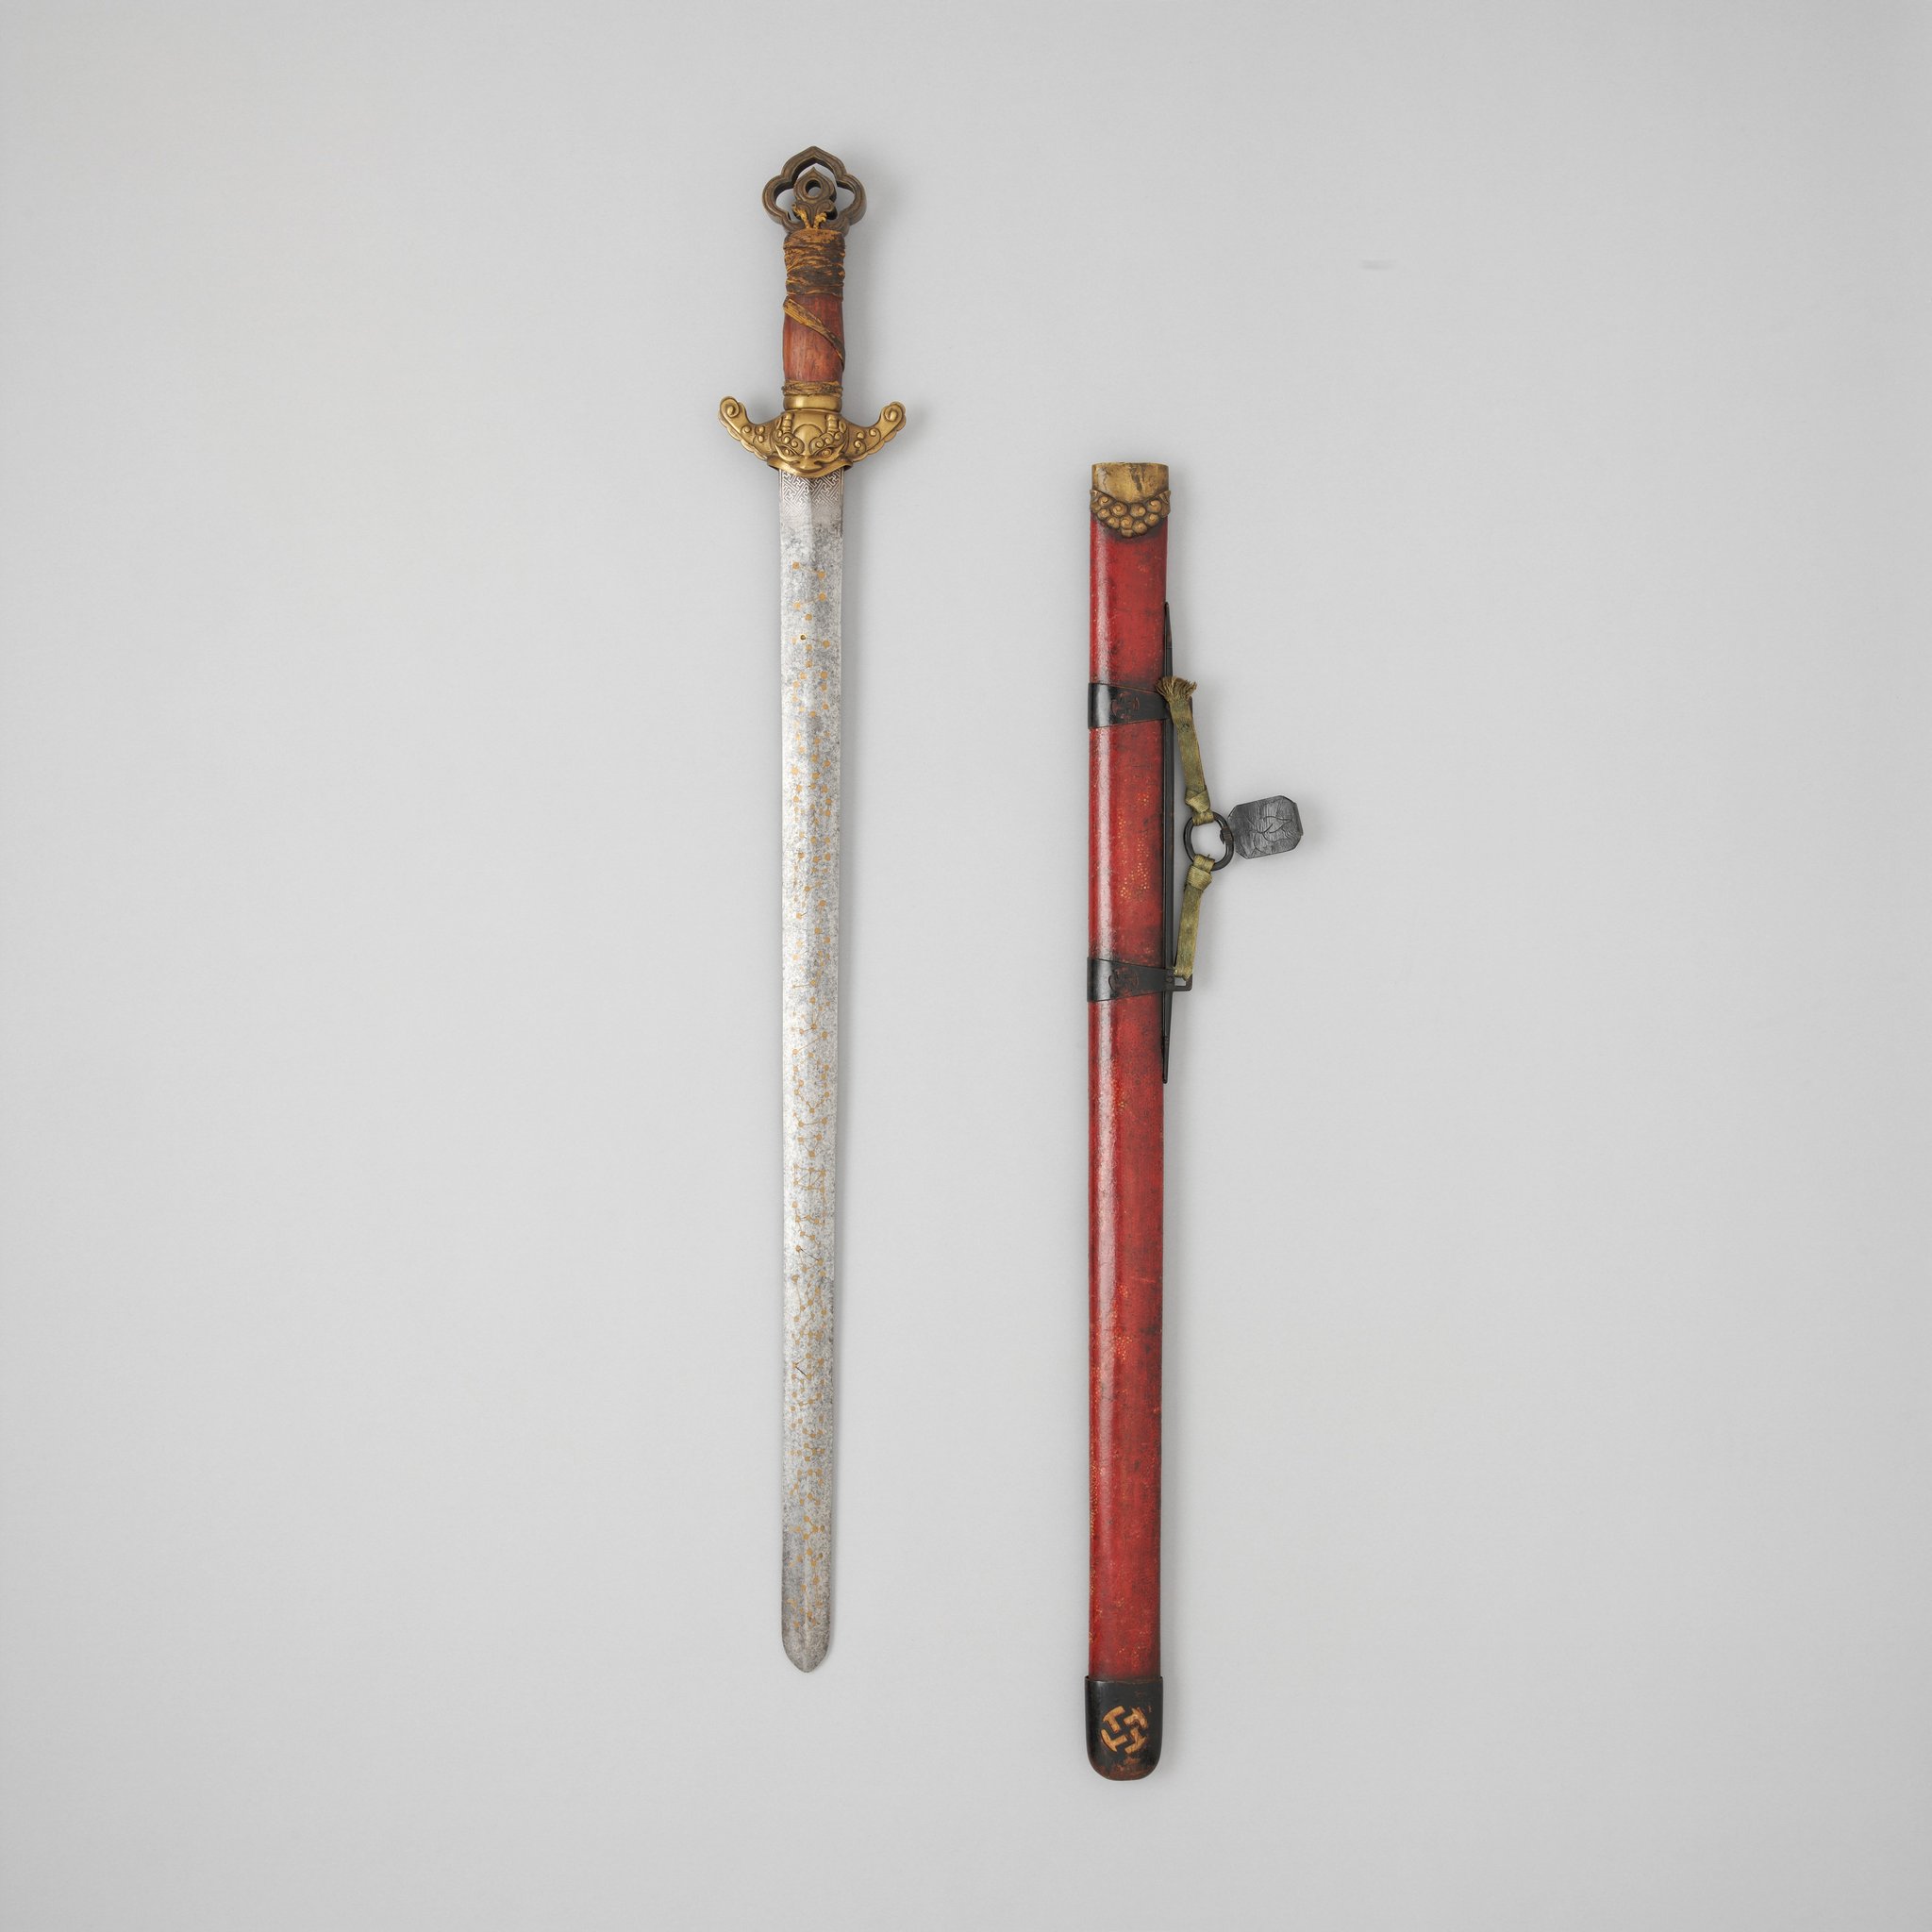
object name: sword with scabbard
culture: korean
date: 1501-1900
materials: bronze, gold, iron, pigment, silver, steel, textile, wood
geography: korea